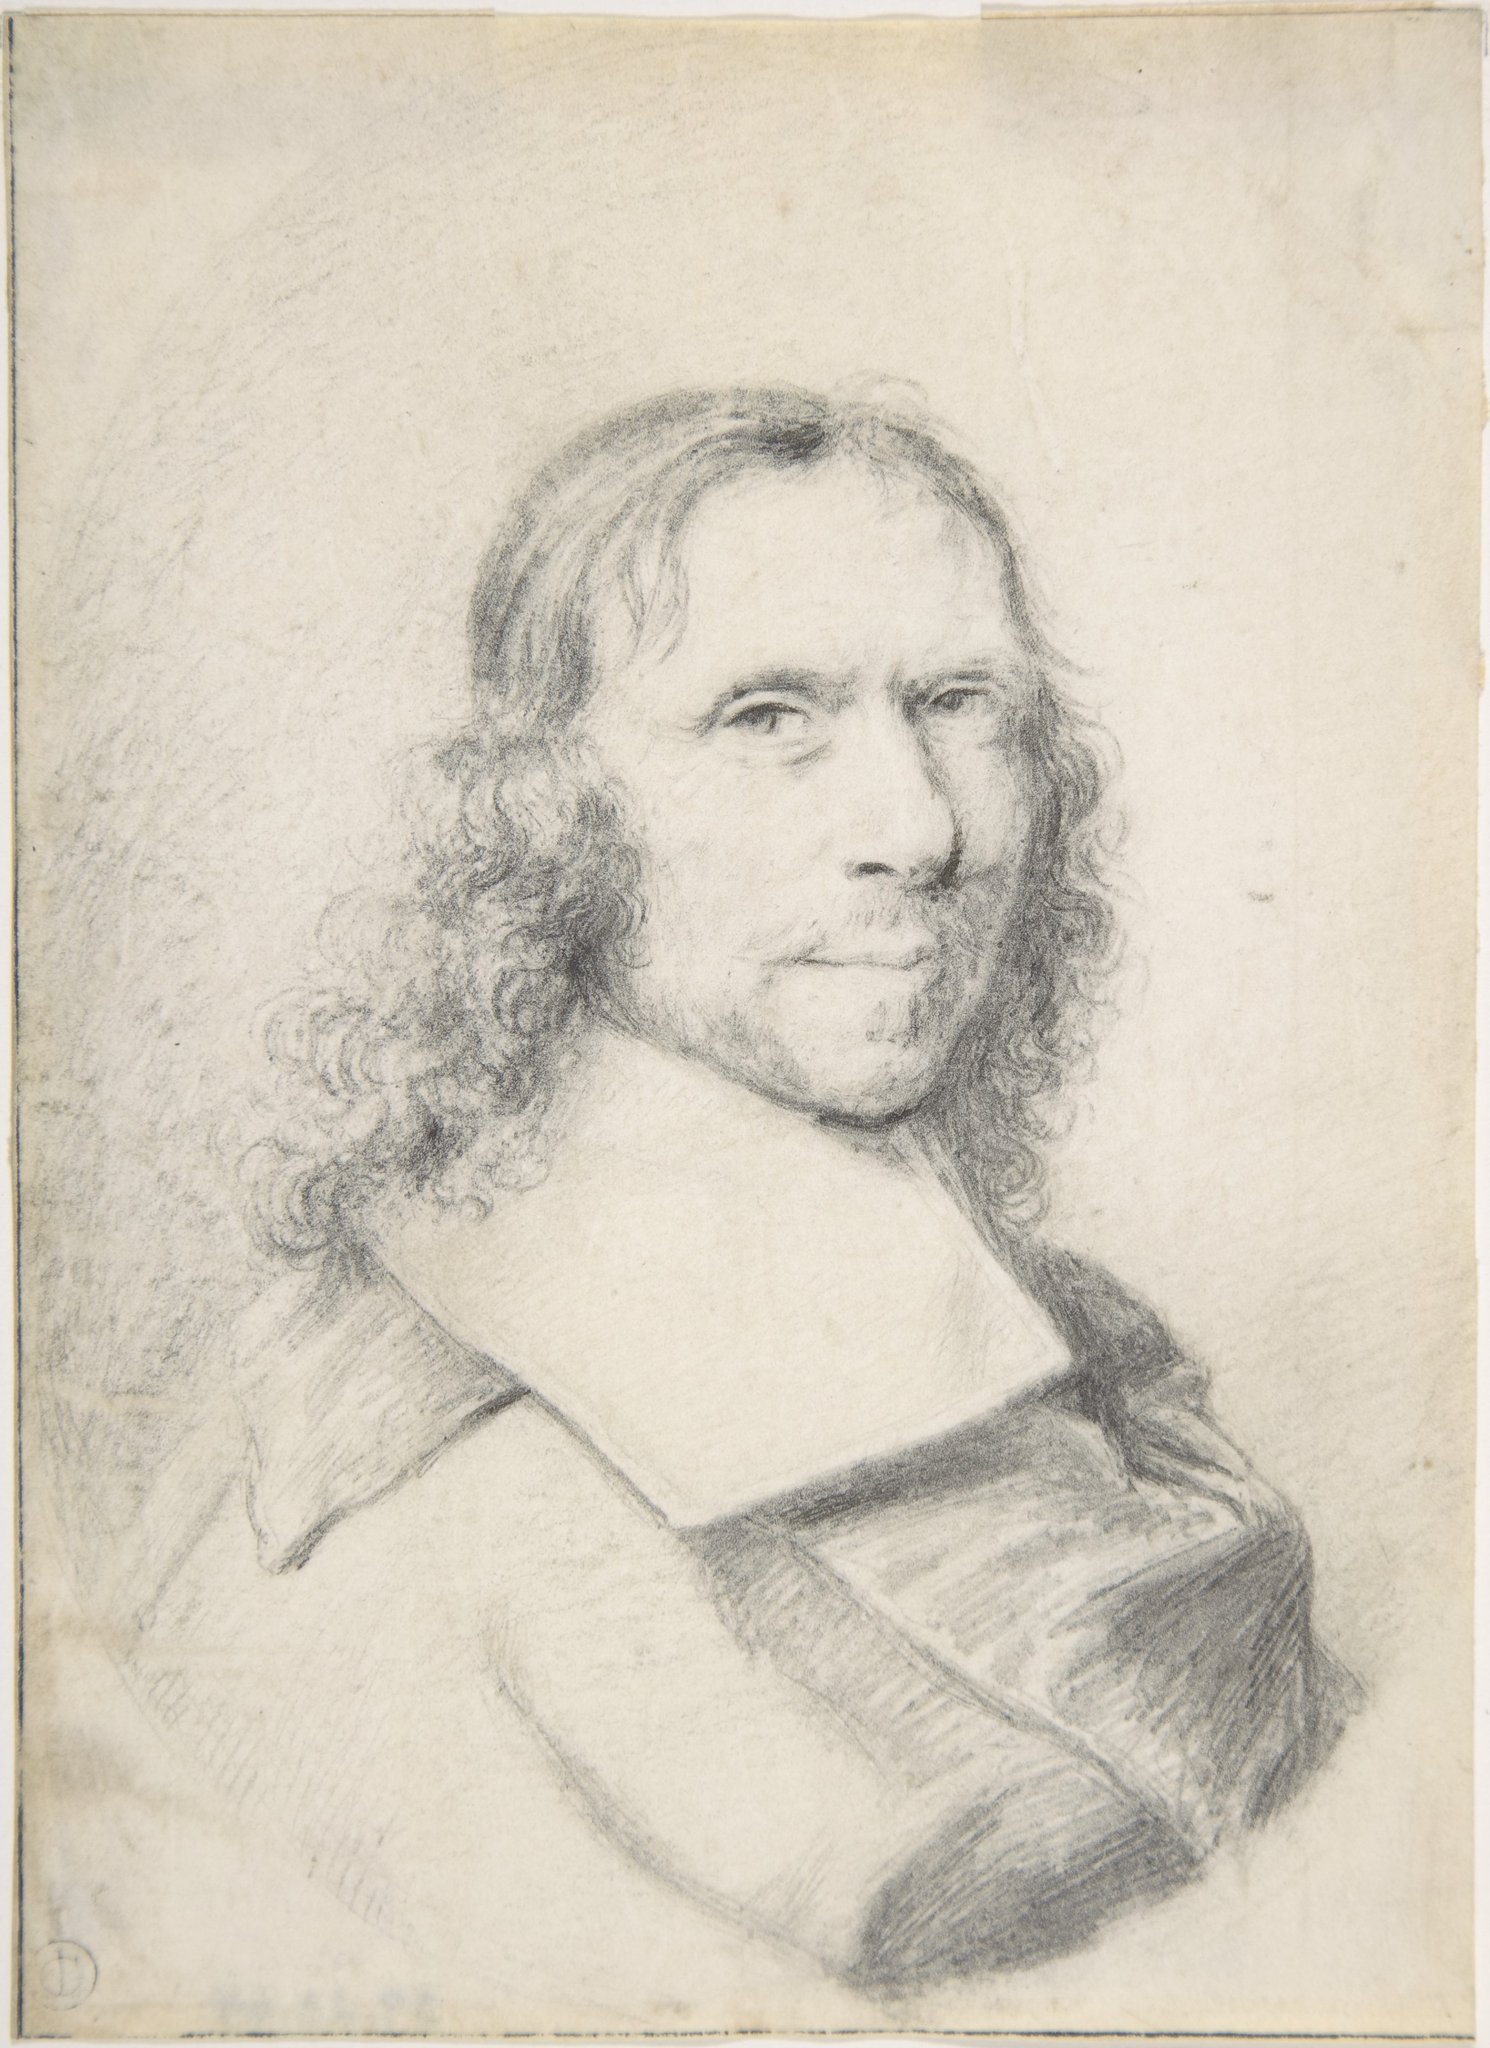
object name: drawing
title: Bust of a Man with a Broad Collar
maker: anonymous, french, 17th century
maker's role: artist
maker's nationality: french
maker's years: 1600-1700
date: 1601-1700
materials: graphite, ink, parchment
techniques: pen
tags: men,portraits